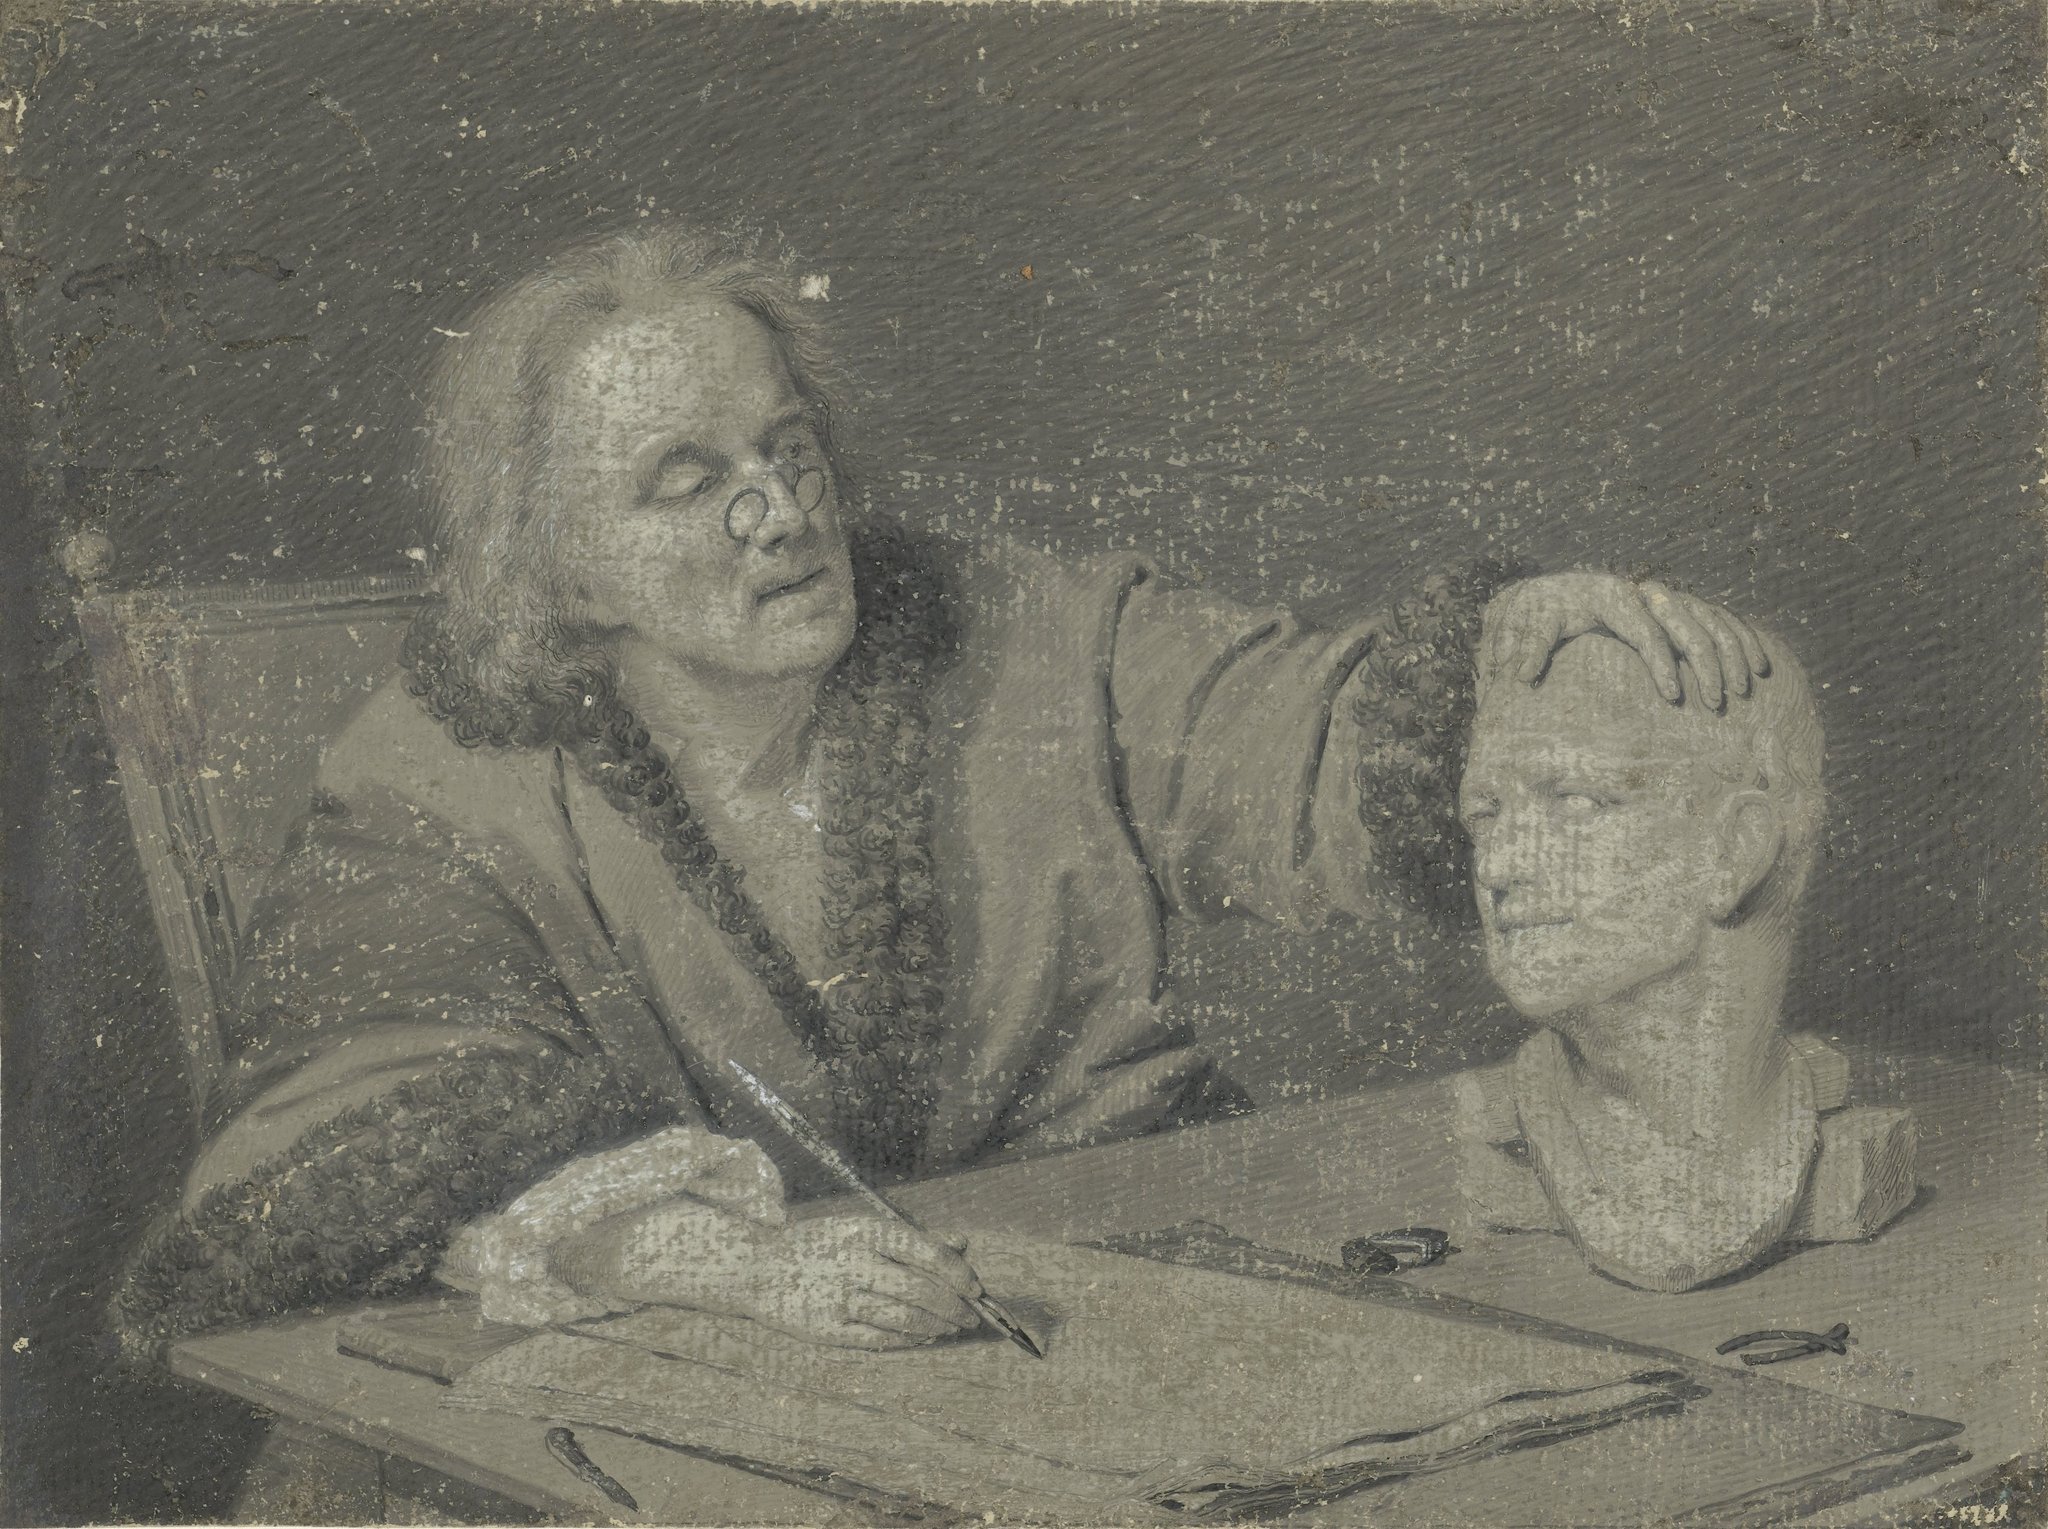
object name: drawing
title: Tekenaar die een gipskop schetst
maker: carl heinrich mylius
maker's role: draughtsman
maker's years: 1734-1758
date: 1756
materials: paper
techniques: brush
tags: draughtsman at work, piece of sculpture, reproduction of a piece of sculpture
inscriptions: date: ‘1756’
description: Naar het geschilderd portret van Paul Christiaan Zincke door Christian Friedrich Reinhold Lisiewski.